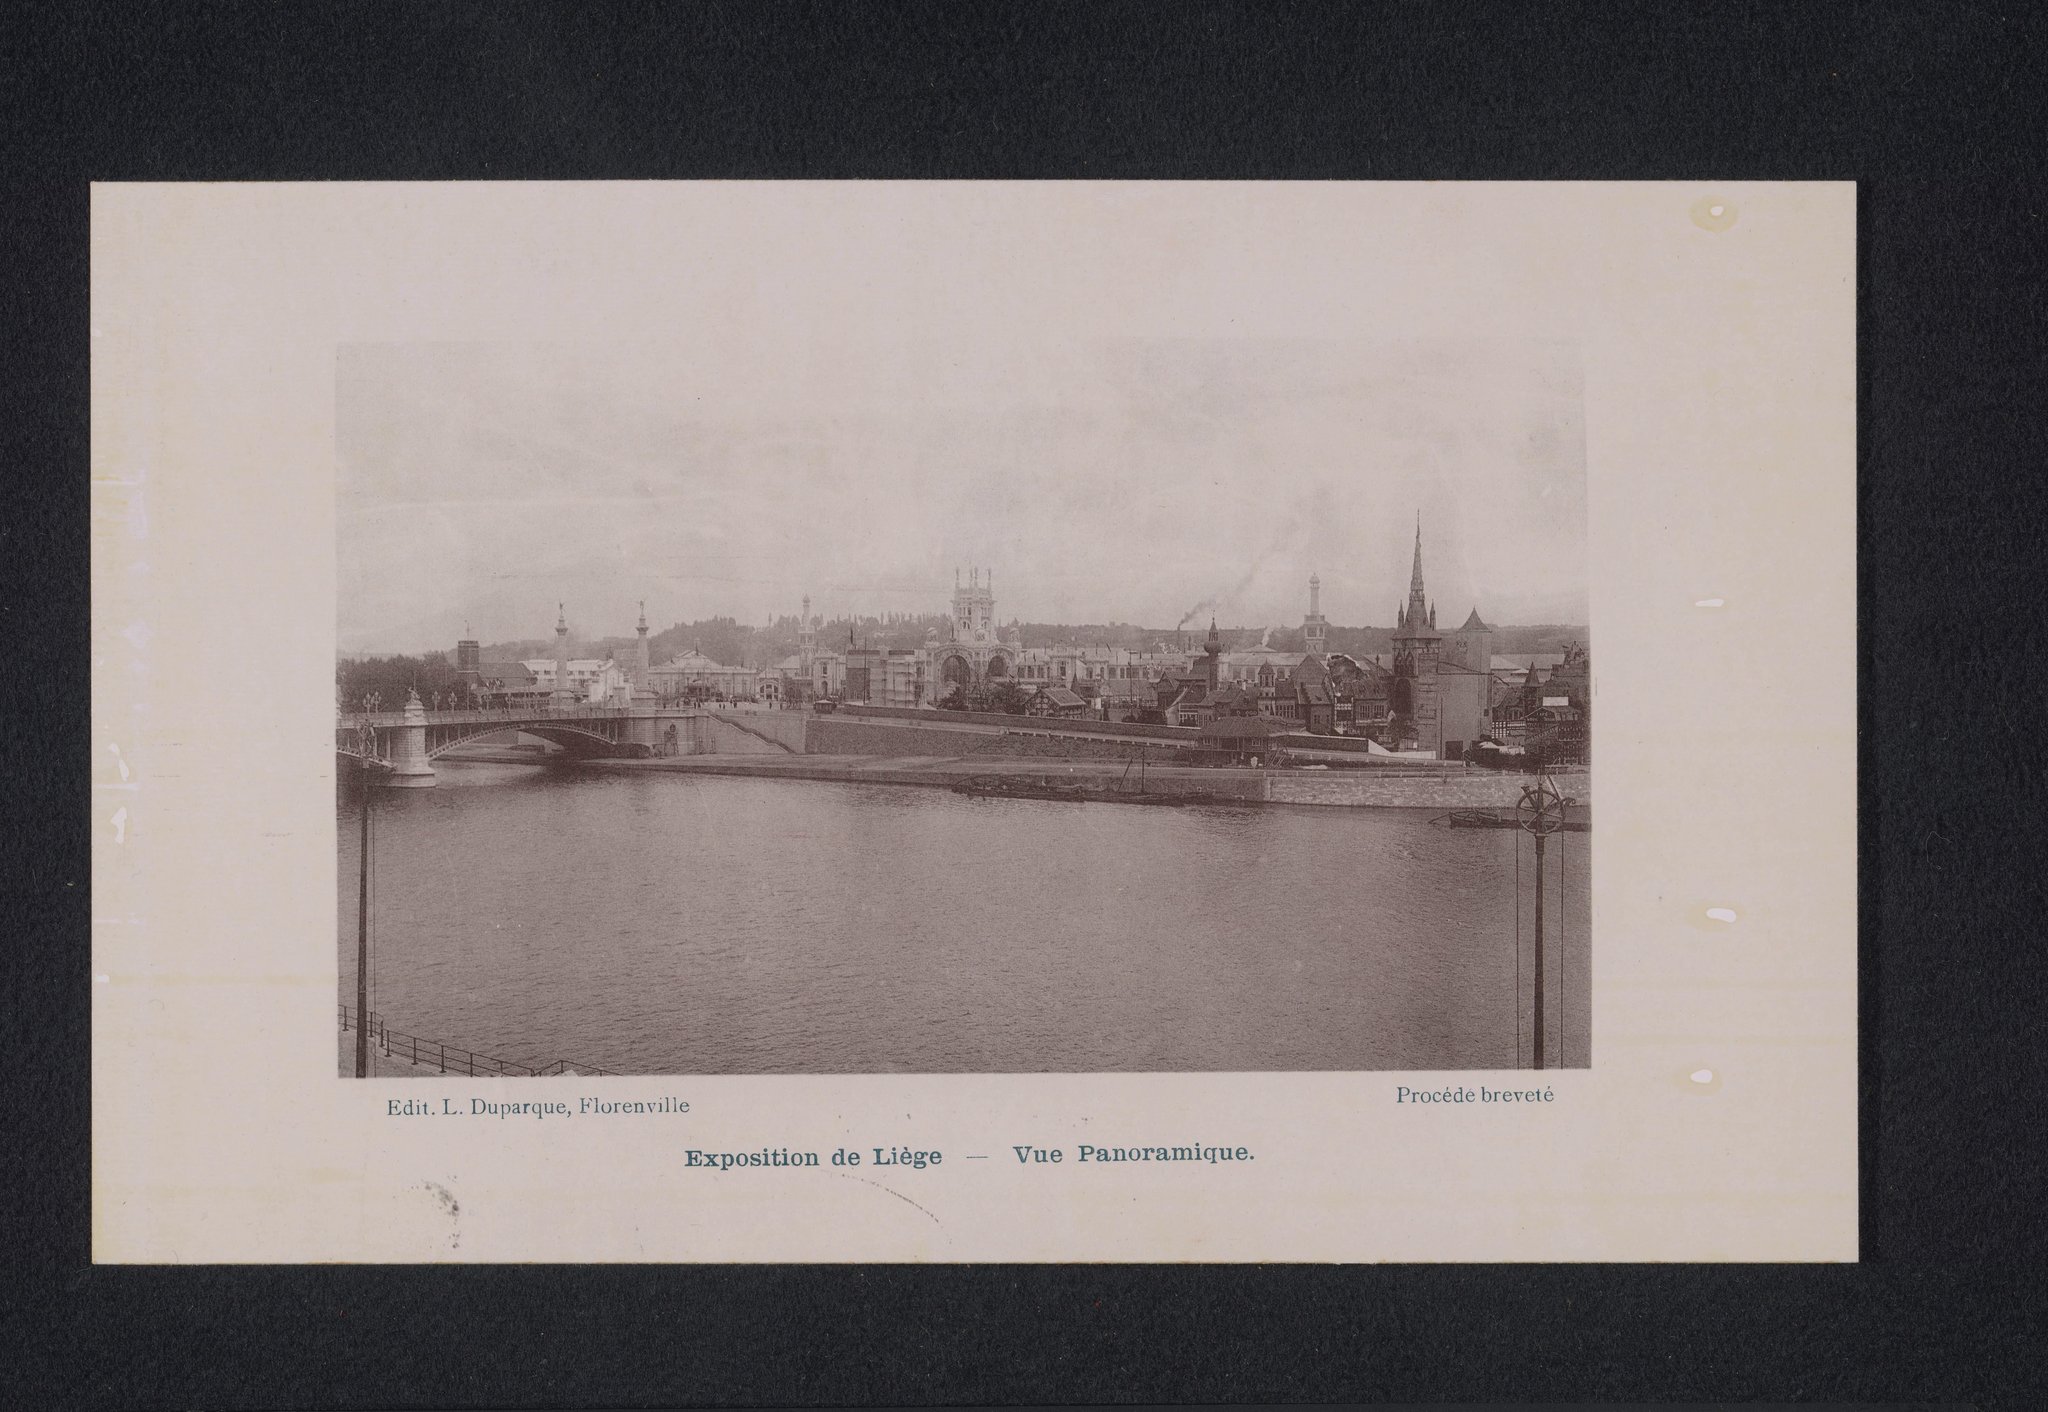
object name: photomechanical print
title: Panorama van de Wereldtentoonstelling van 1905 in Luik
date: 1905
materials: paper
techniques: photograph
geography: liège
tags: world fair, world exhibition, prospect of city, town panorama, silhouette of city, liège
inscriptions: inscription: ‘Procédé breveté’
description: Deze prent maakt deel uit van een omslag met 16 prenten.